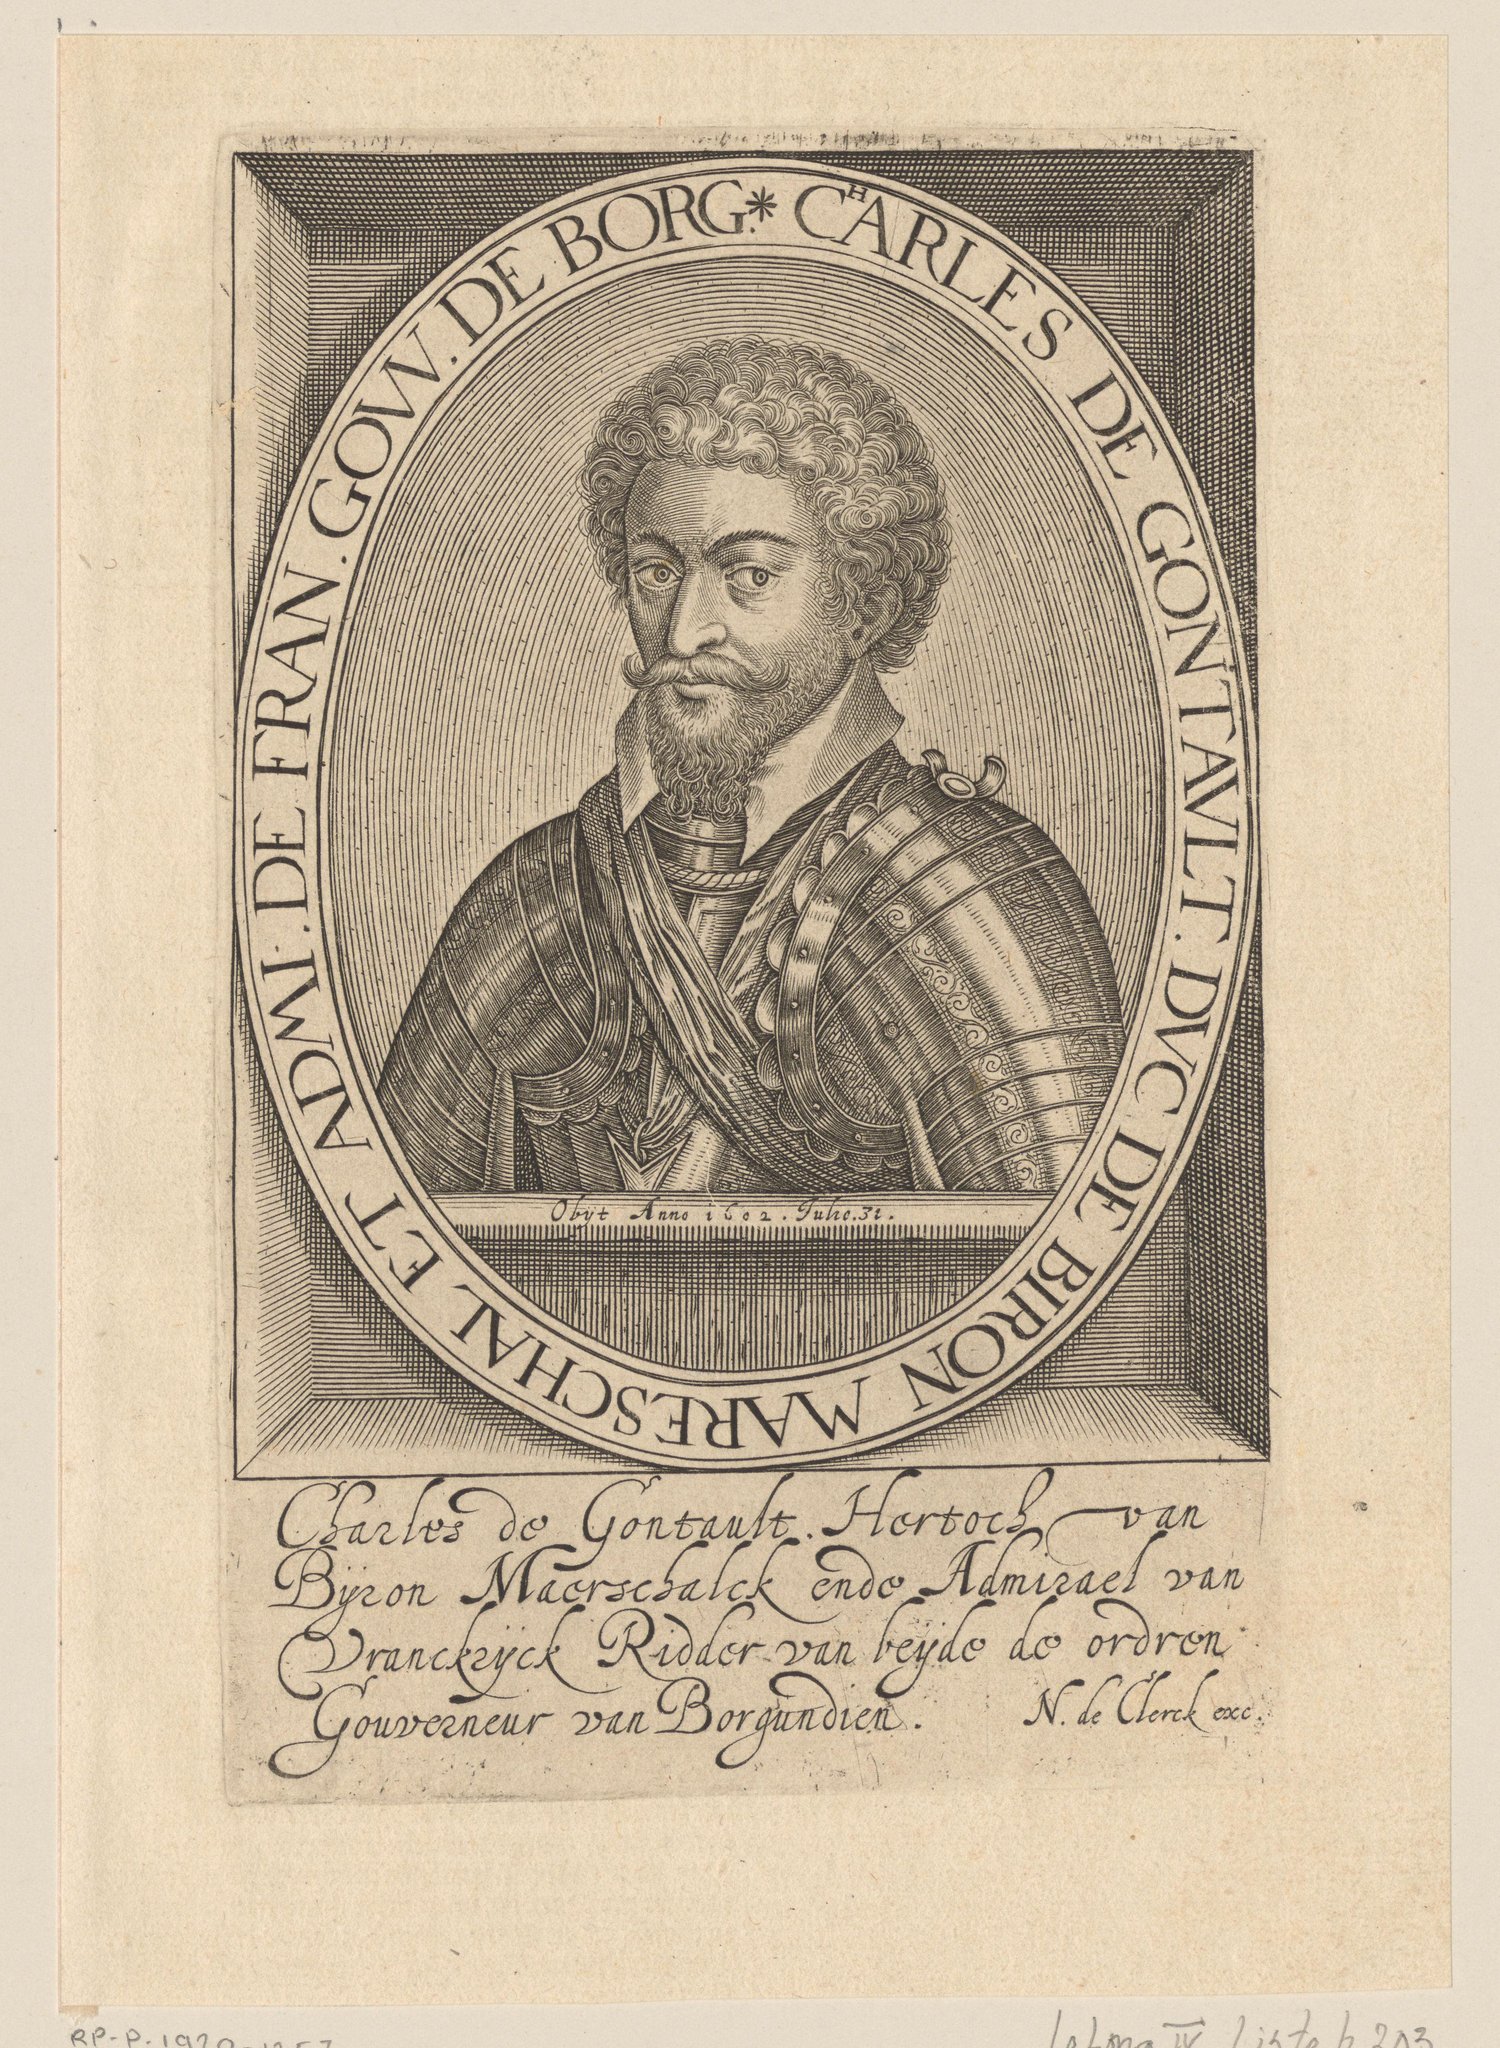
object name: print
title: Portret van Charles de Gontaut, heer van Biron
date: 1599-1623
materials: paper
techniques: engraving, etching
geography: delft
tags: paris, armour, historical persons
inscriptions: collector's mark: Lugt 2228